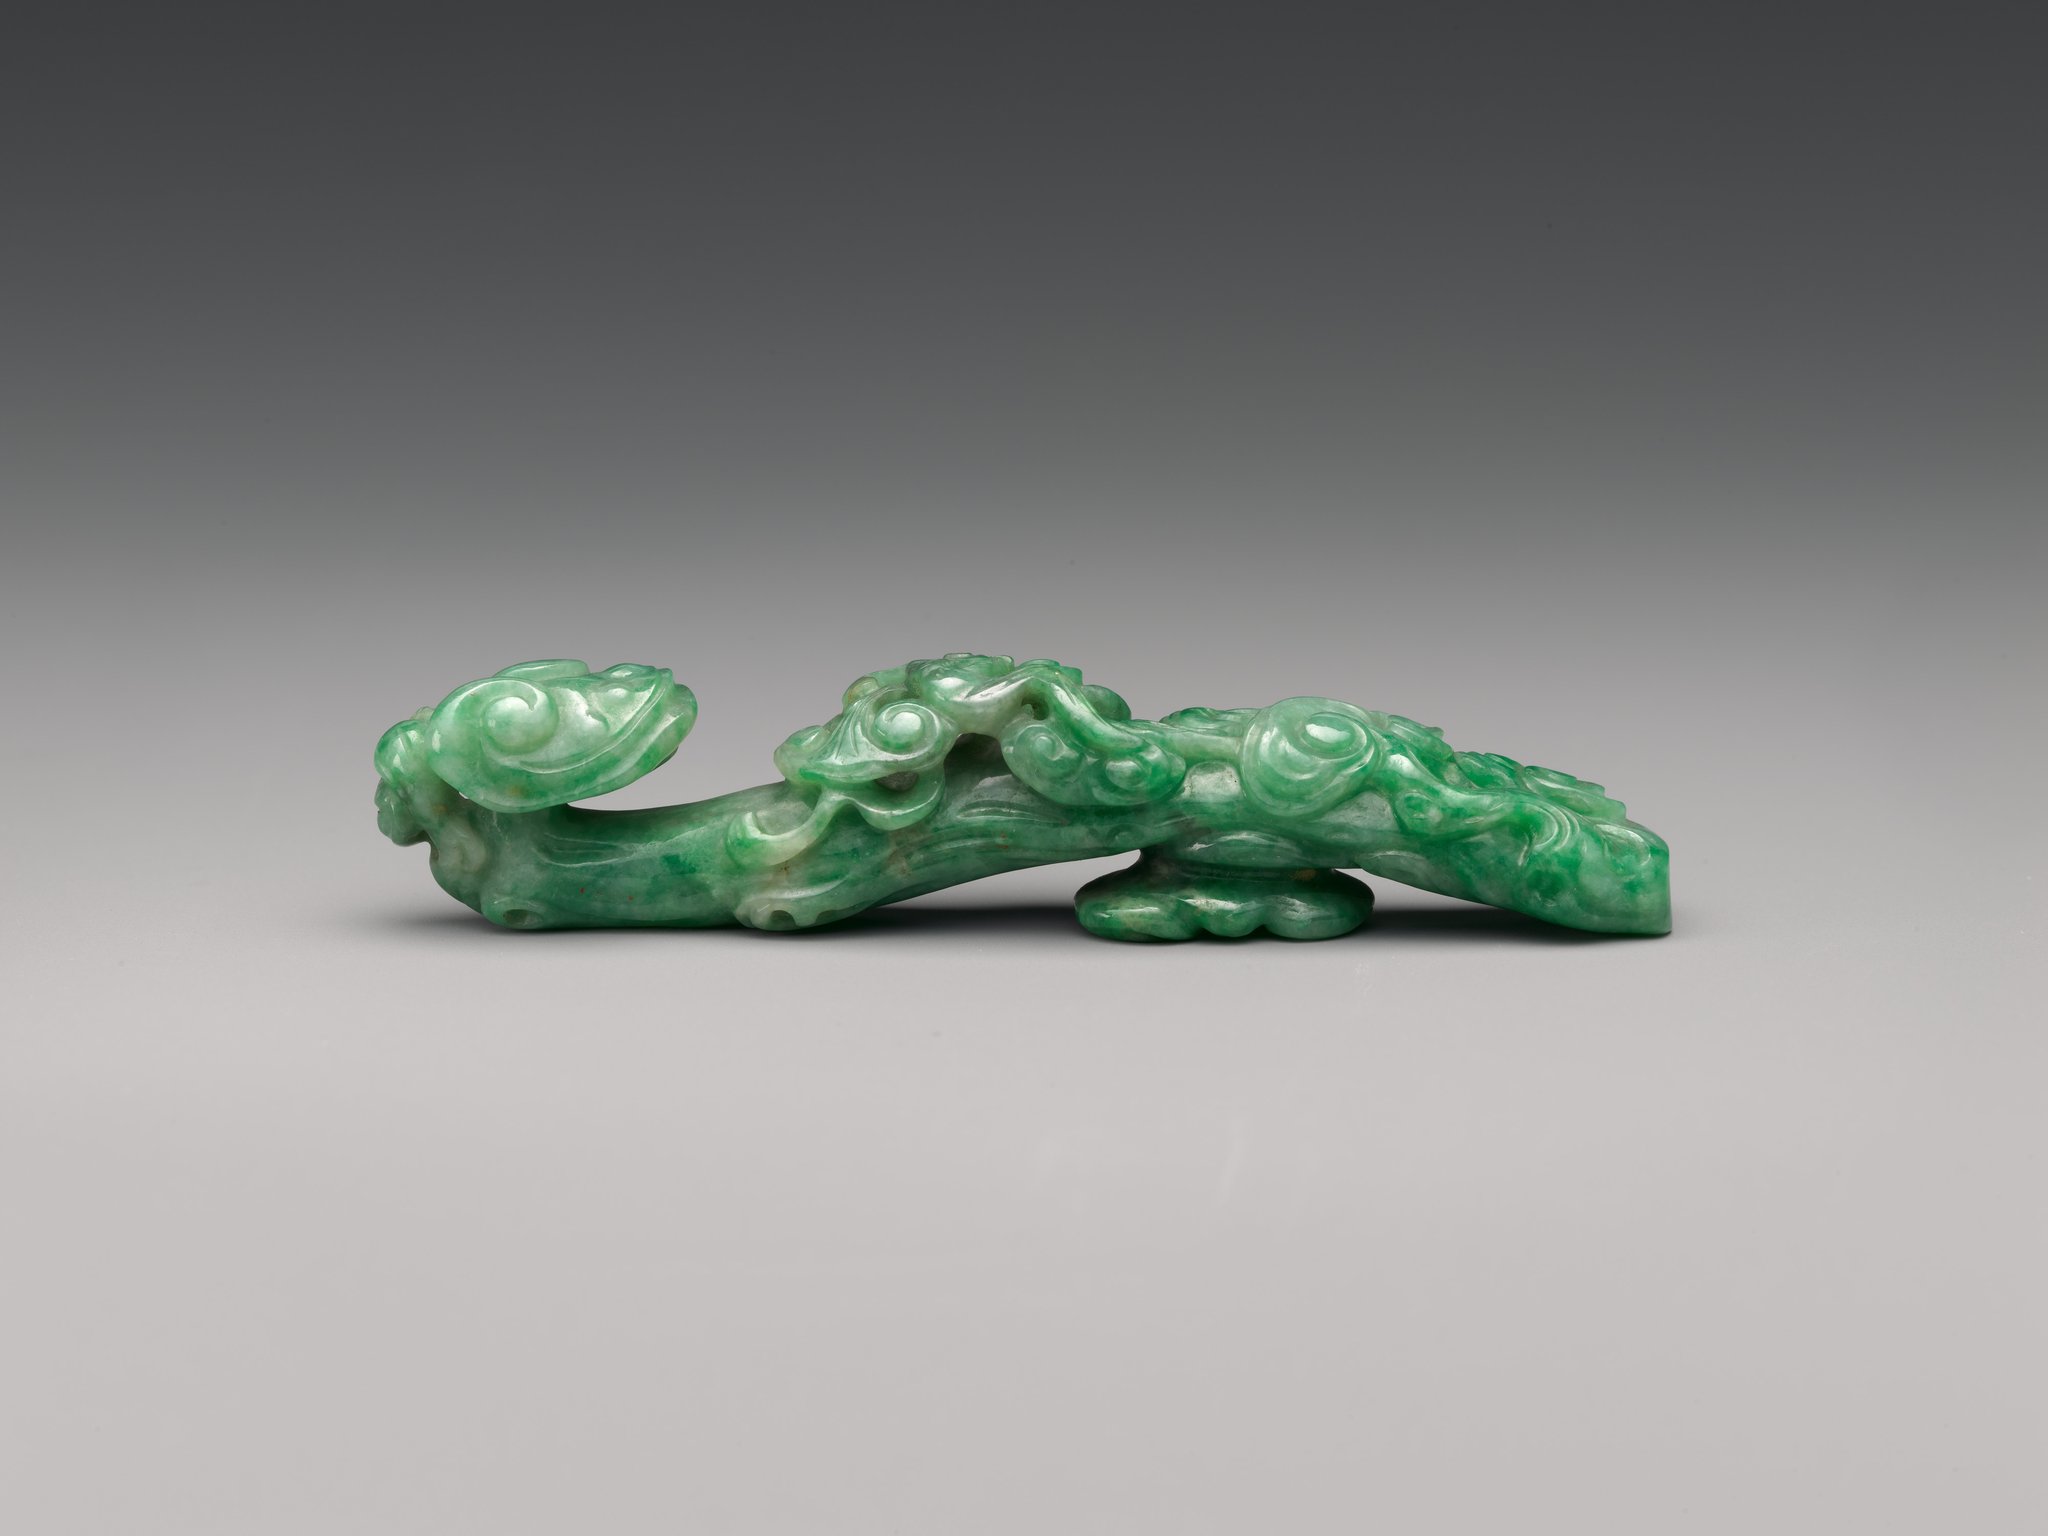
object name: garment hook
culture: chinese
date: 1801-1900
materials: jade